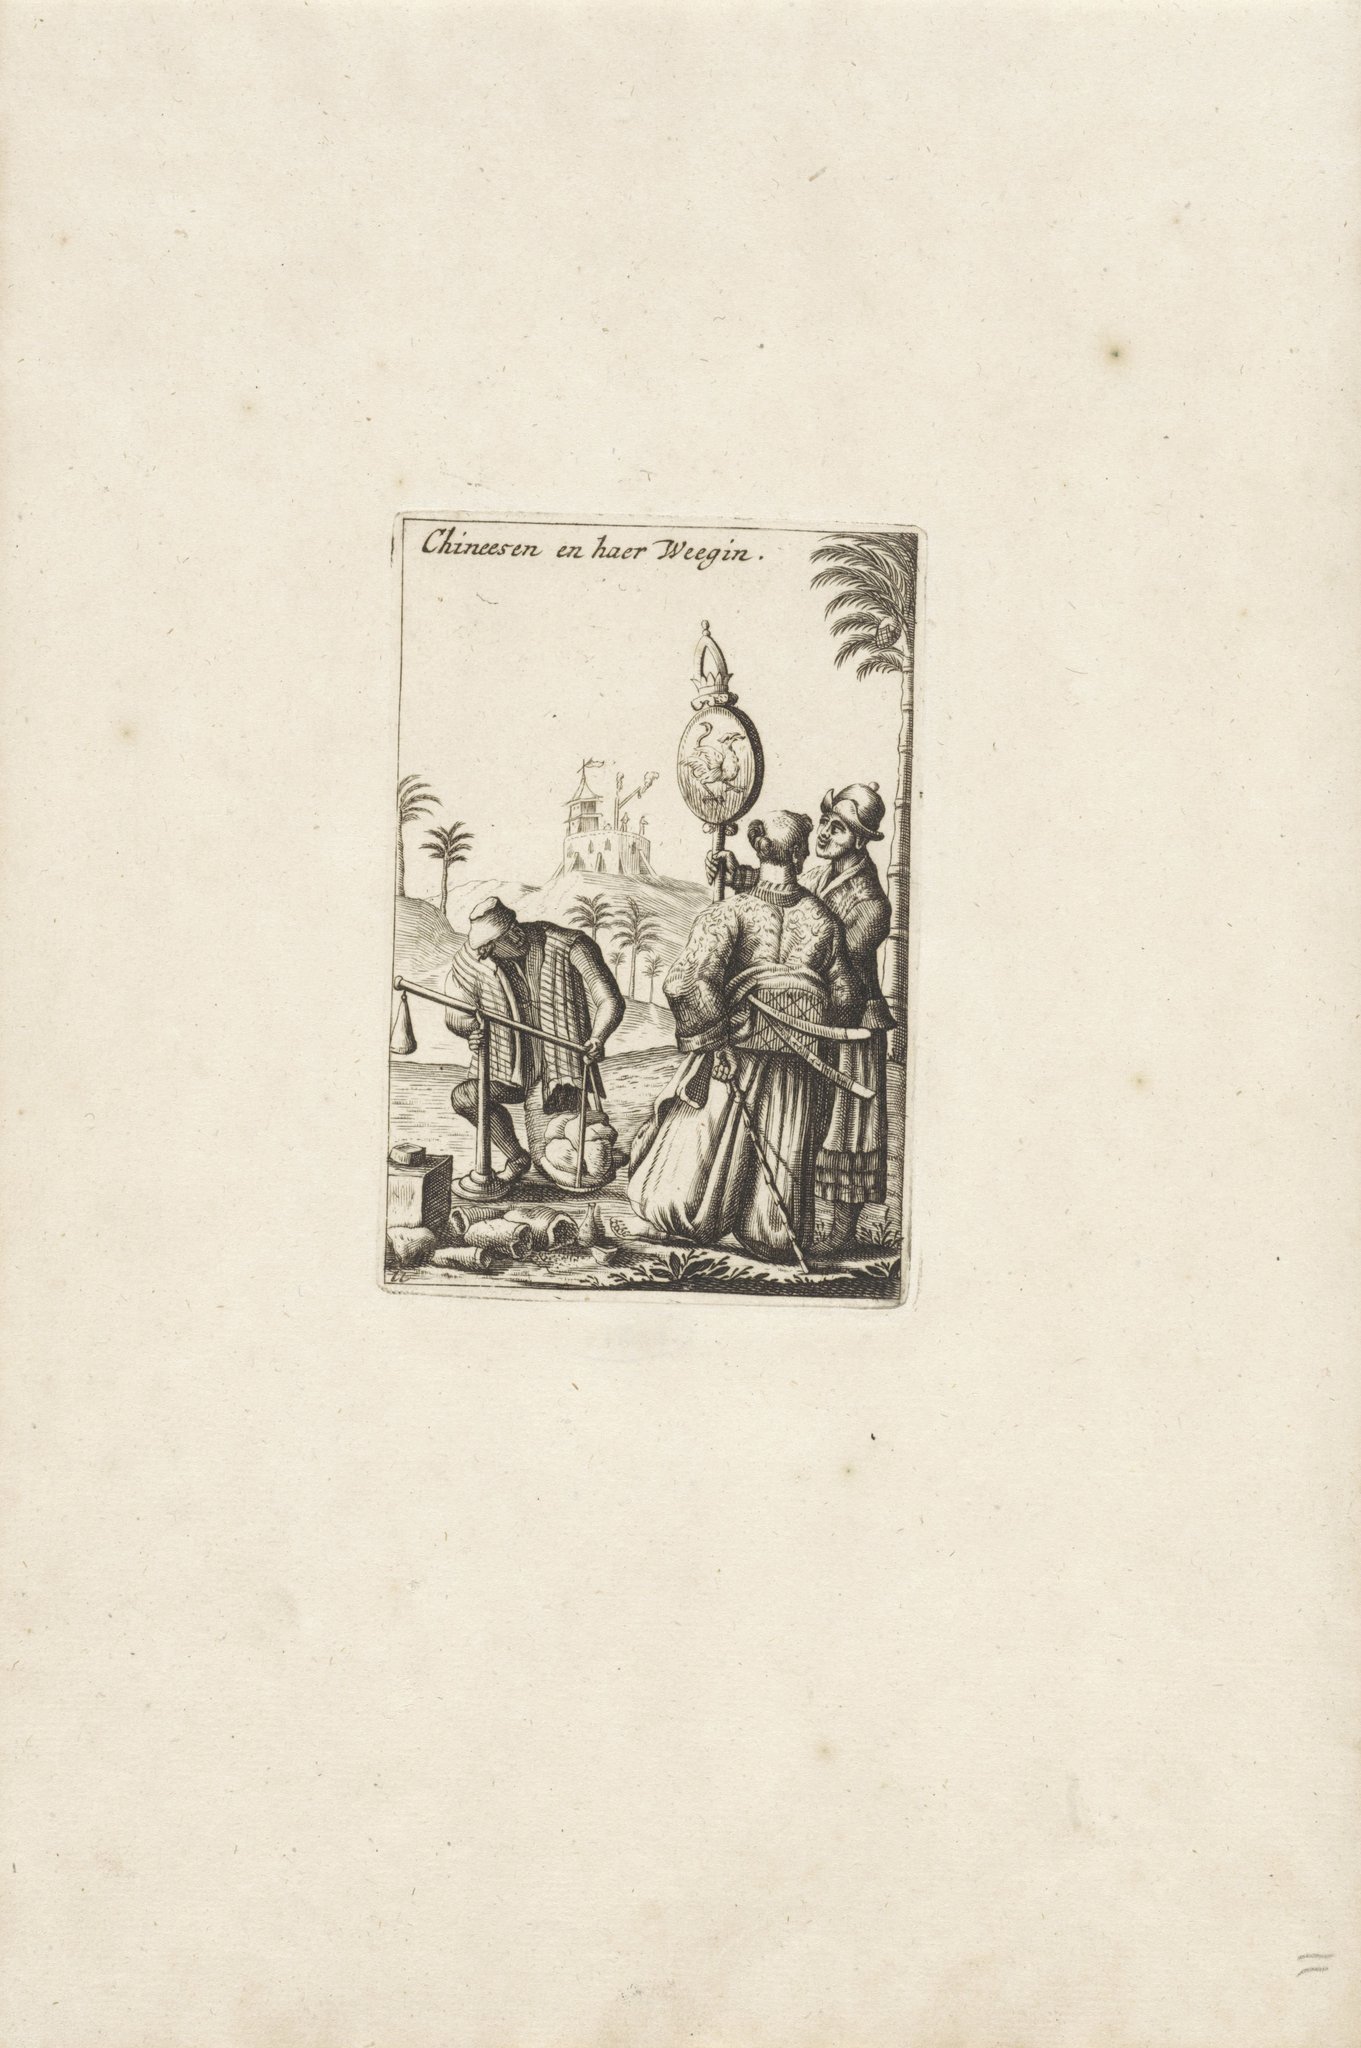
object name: print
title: Chinese mensen en hun weeg- en meetgebruiken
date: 1682-1711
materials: paper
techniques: etching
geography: amsterdam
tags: weighing, chinese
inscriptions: collector's mark: Lugt 2228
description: Deze serie bestaat uit kopieën naar de prenten in: Vries, Simon de. Curieuse aenmerckingen der bysonderste Oost en West-Indische verwonderens-waerdige dingen. Utrecht: Johannes Ribbius, 1682.